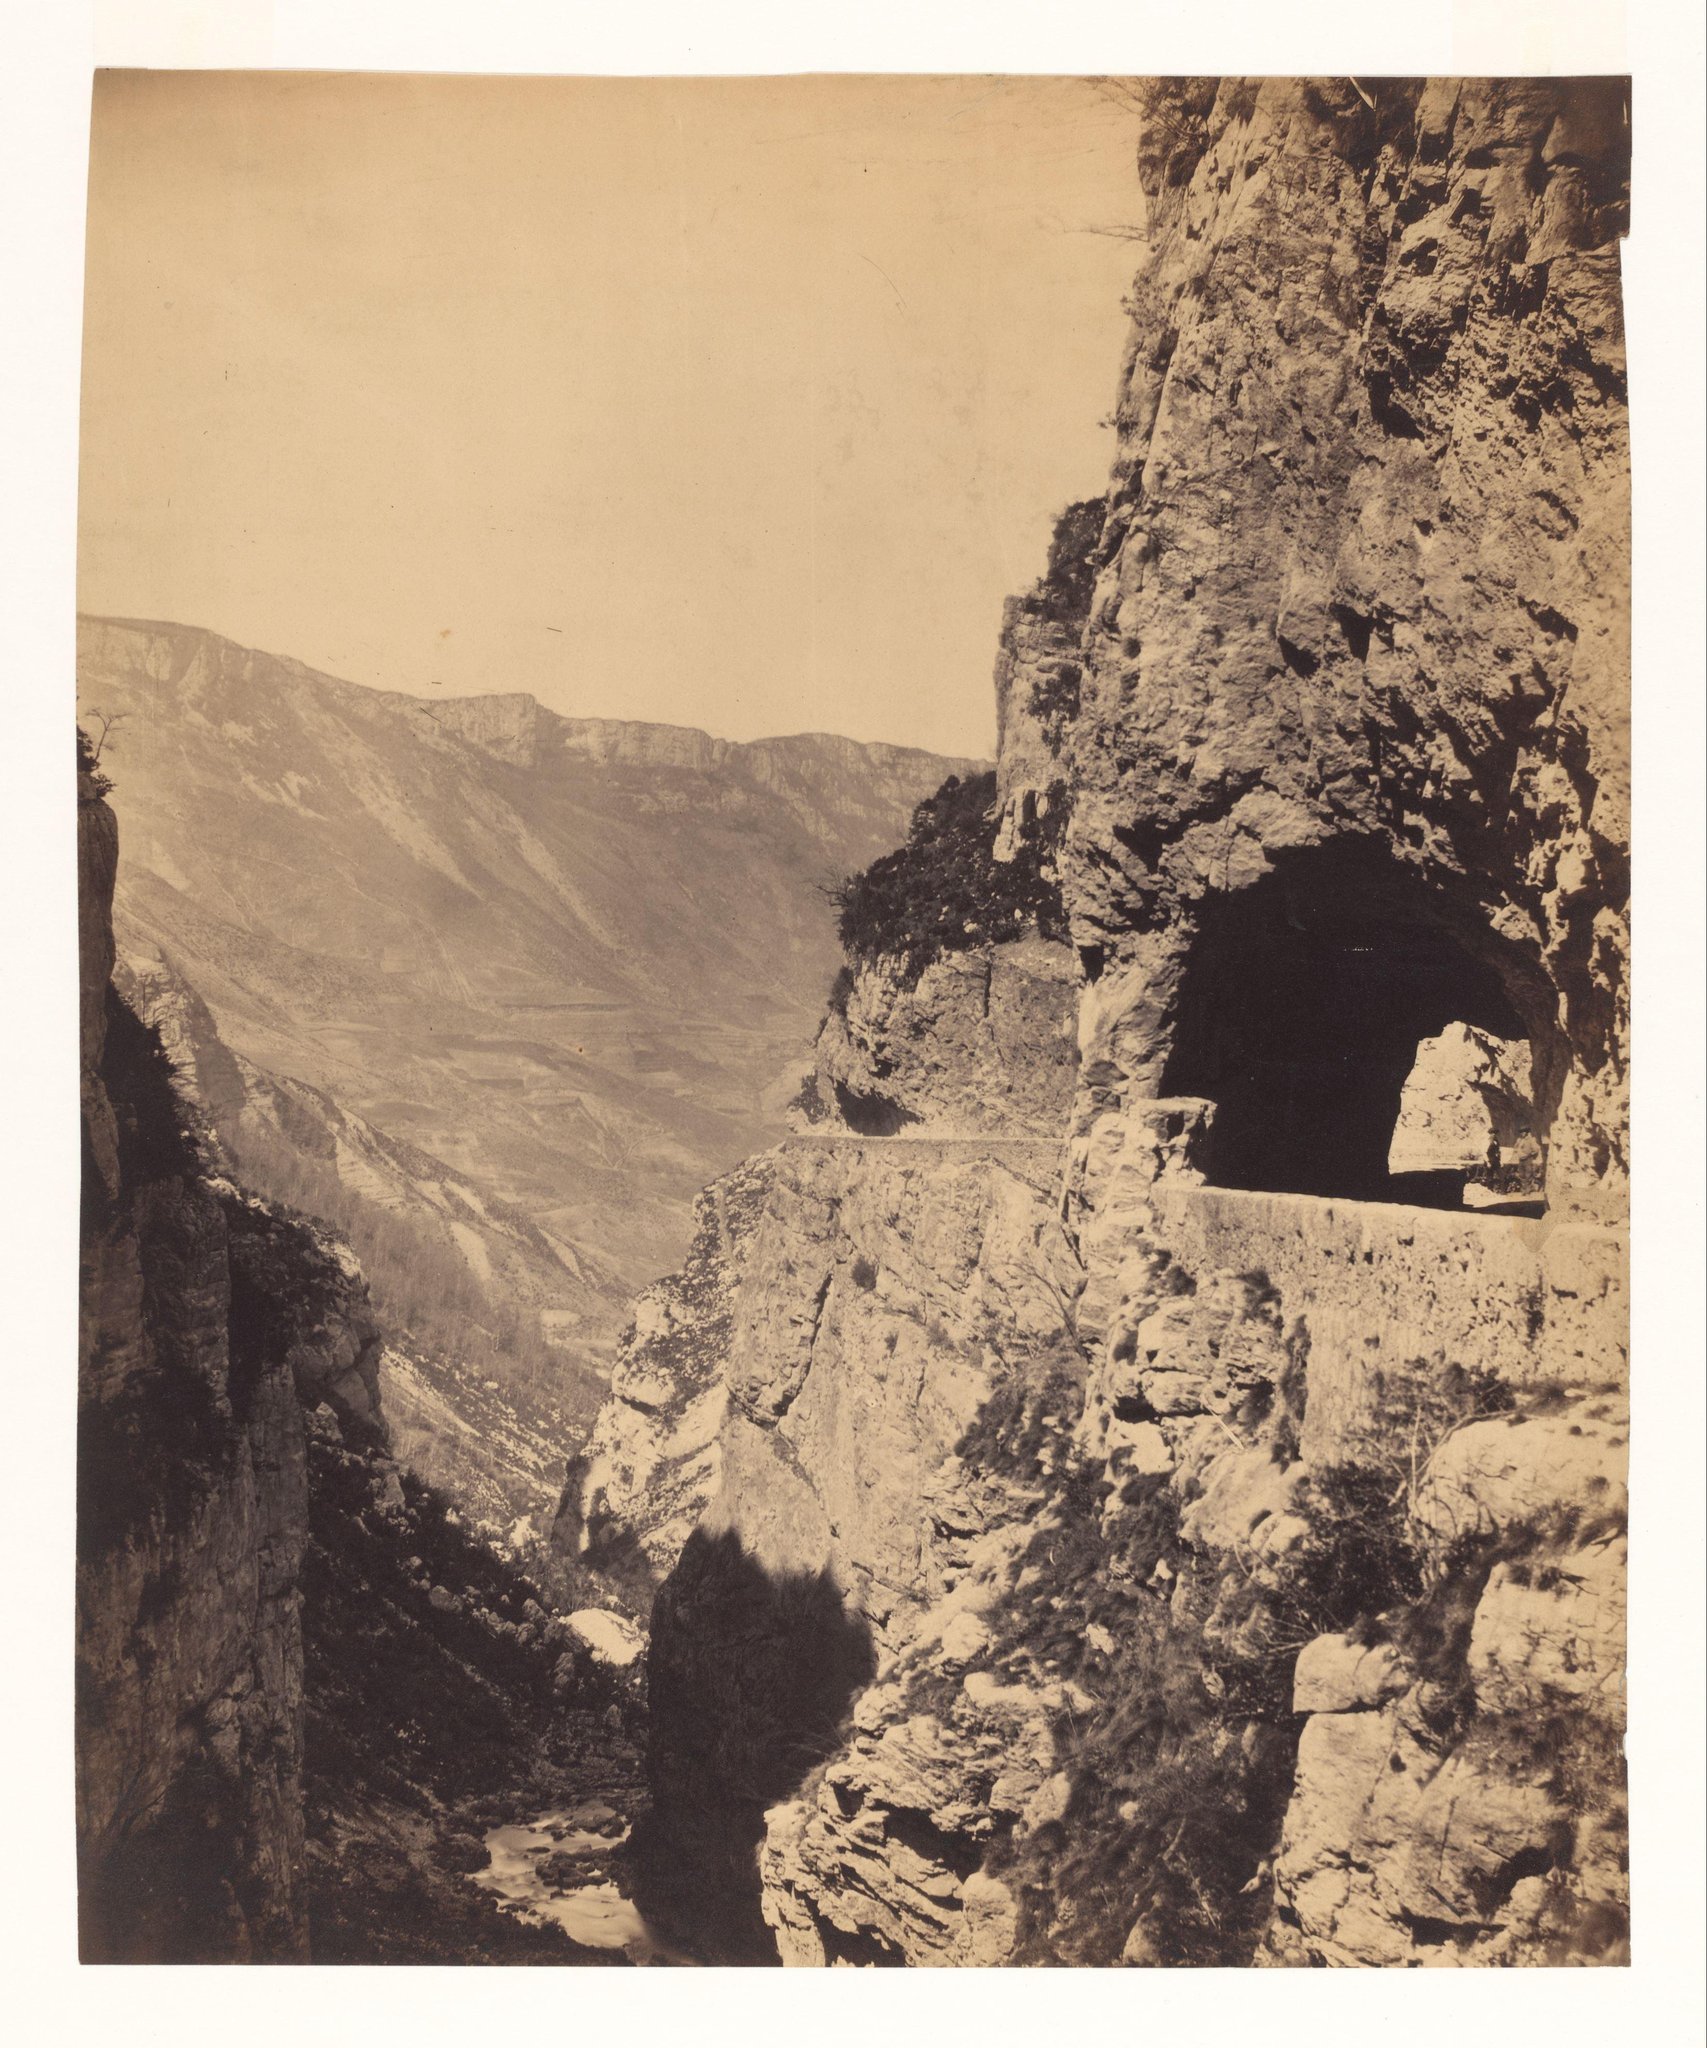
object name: photograph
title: Berglandschap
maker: Anonymous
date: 1850-1890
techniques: albumen print